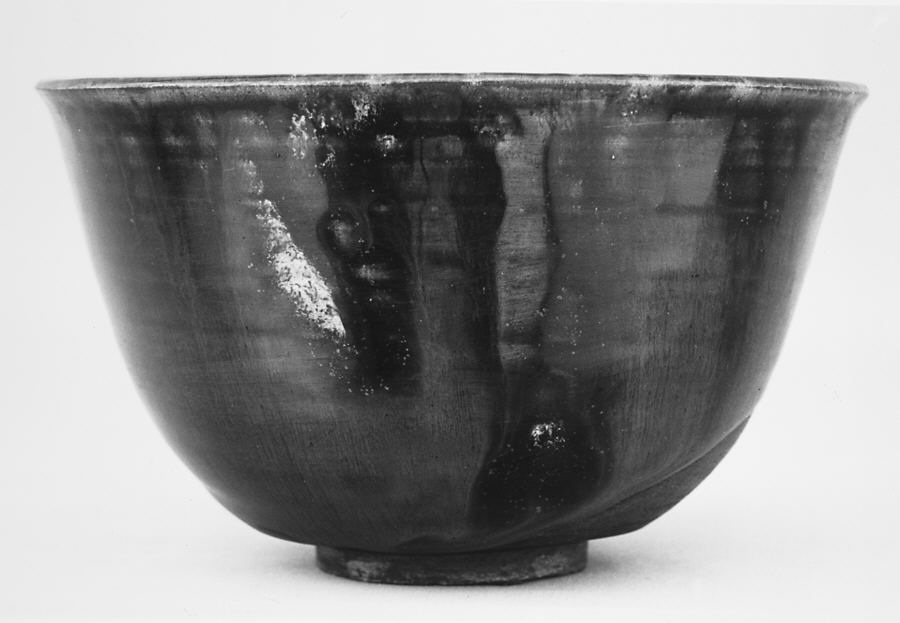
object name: bowl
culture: japanese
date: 1801-1900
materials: clay, glaze